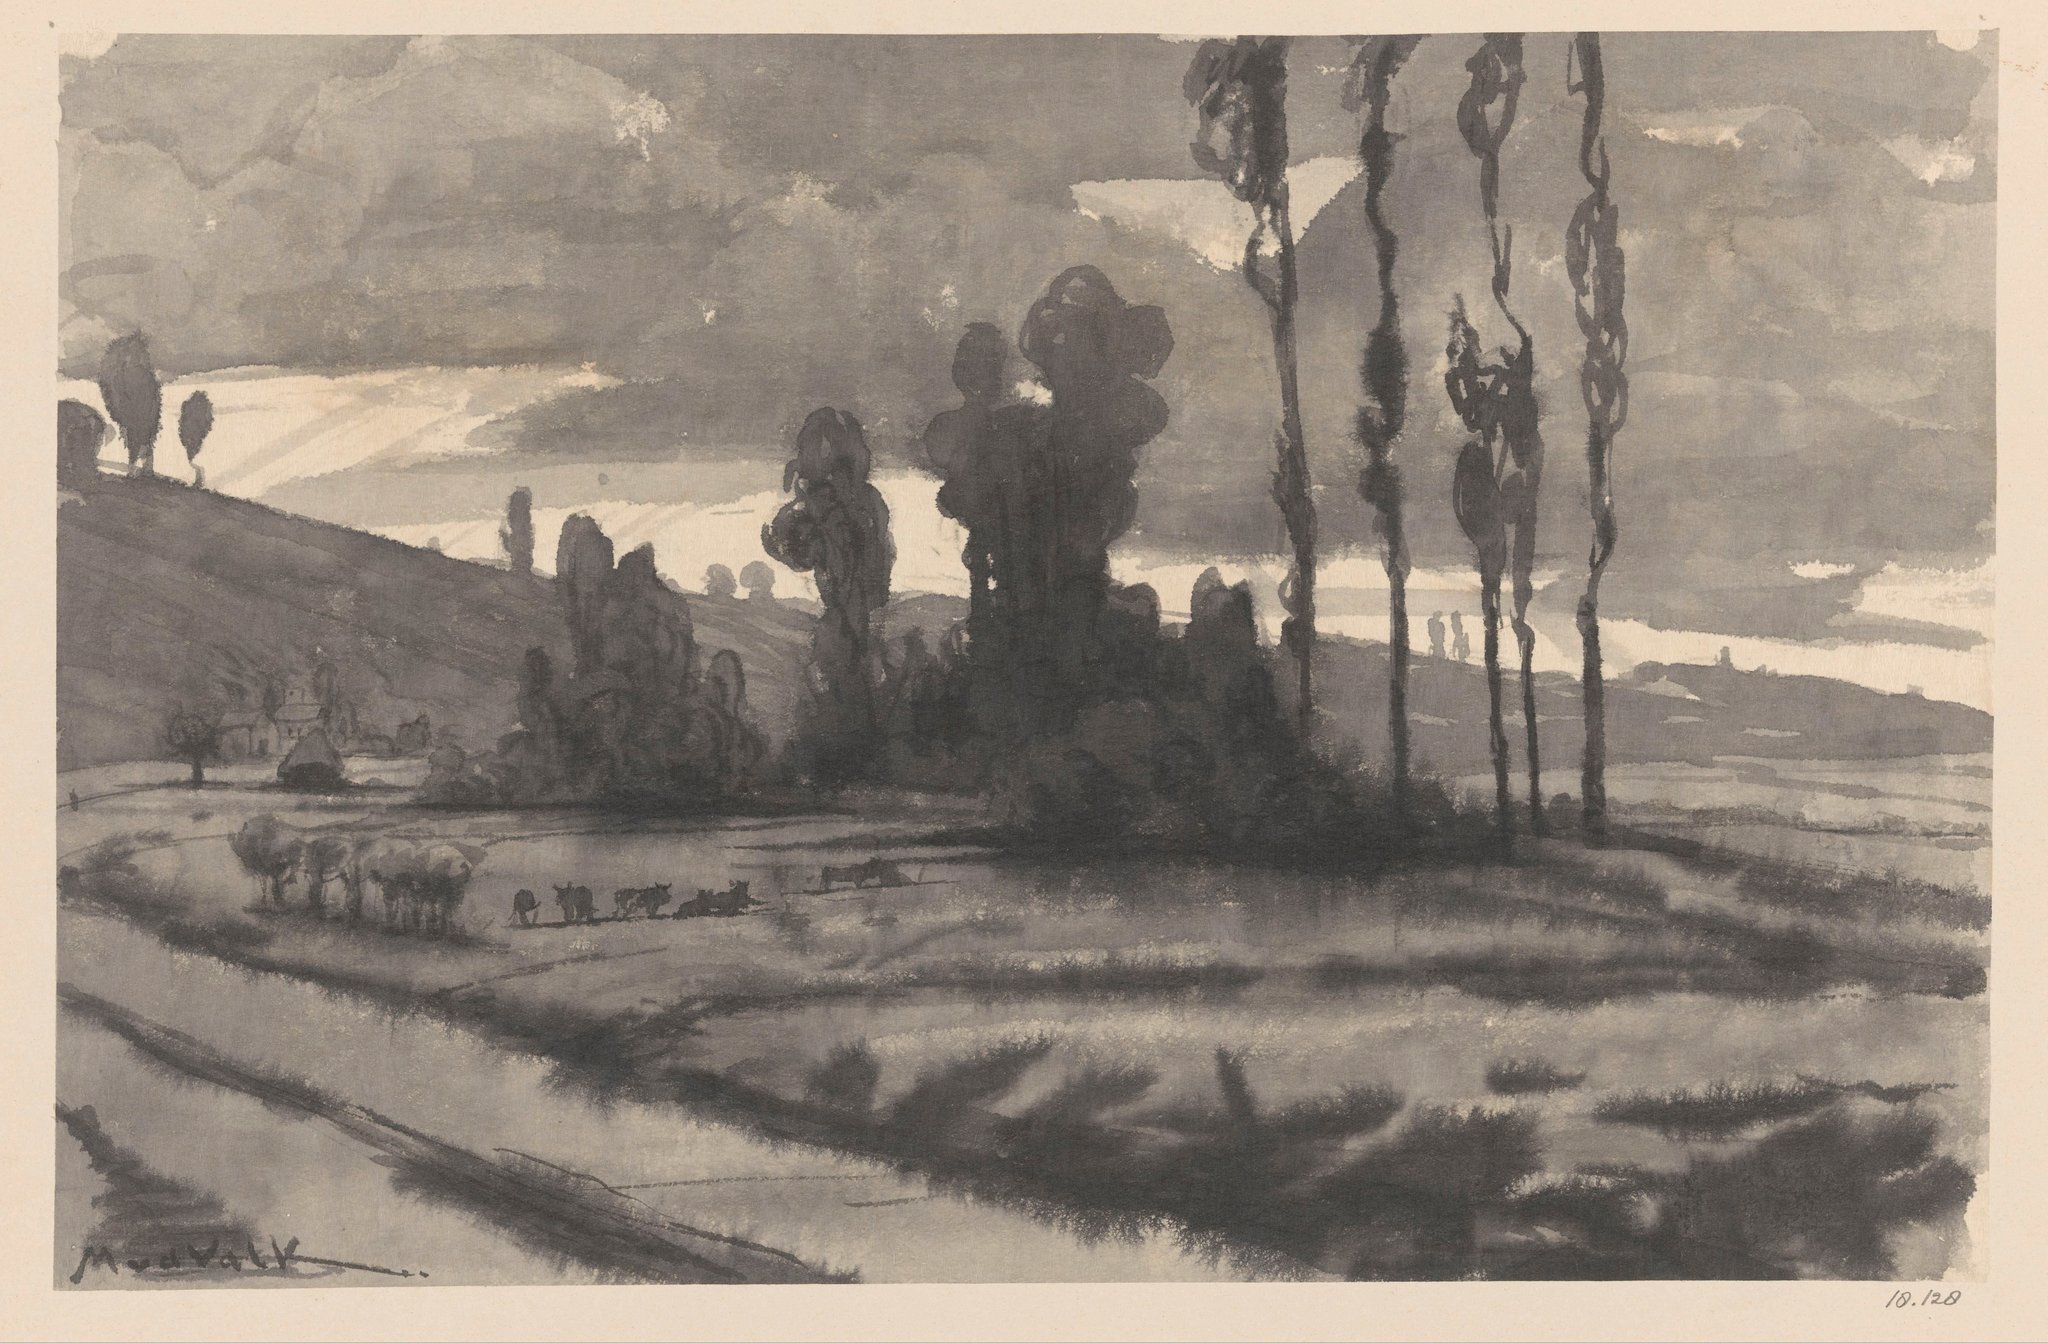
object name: drawing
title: Landschap met koeien in een weiland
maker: maurits van der valk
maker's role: draughtsman, print maker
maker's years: 1857-1935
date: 1867-1918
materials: paper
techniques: brush